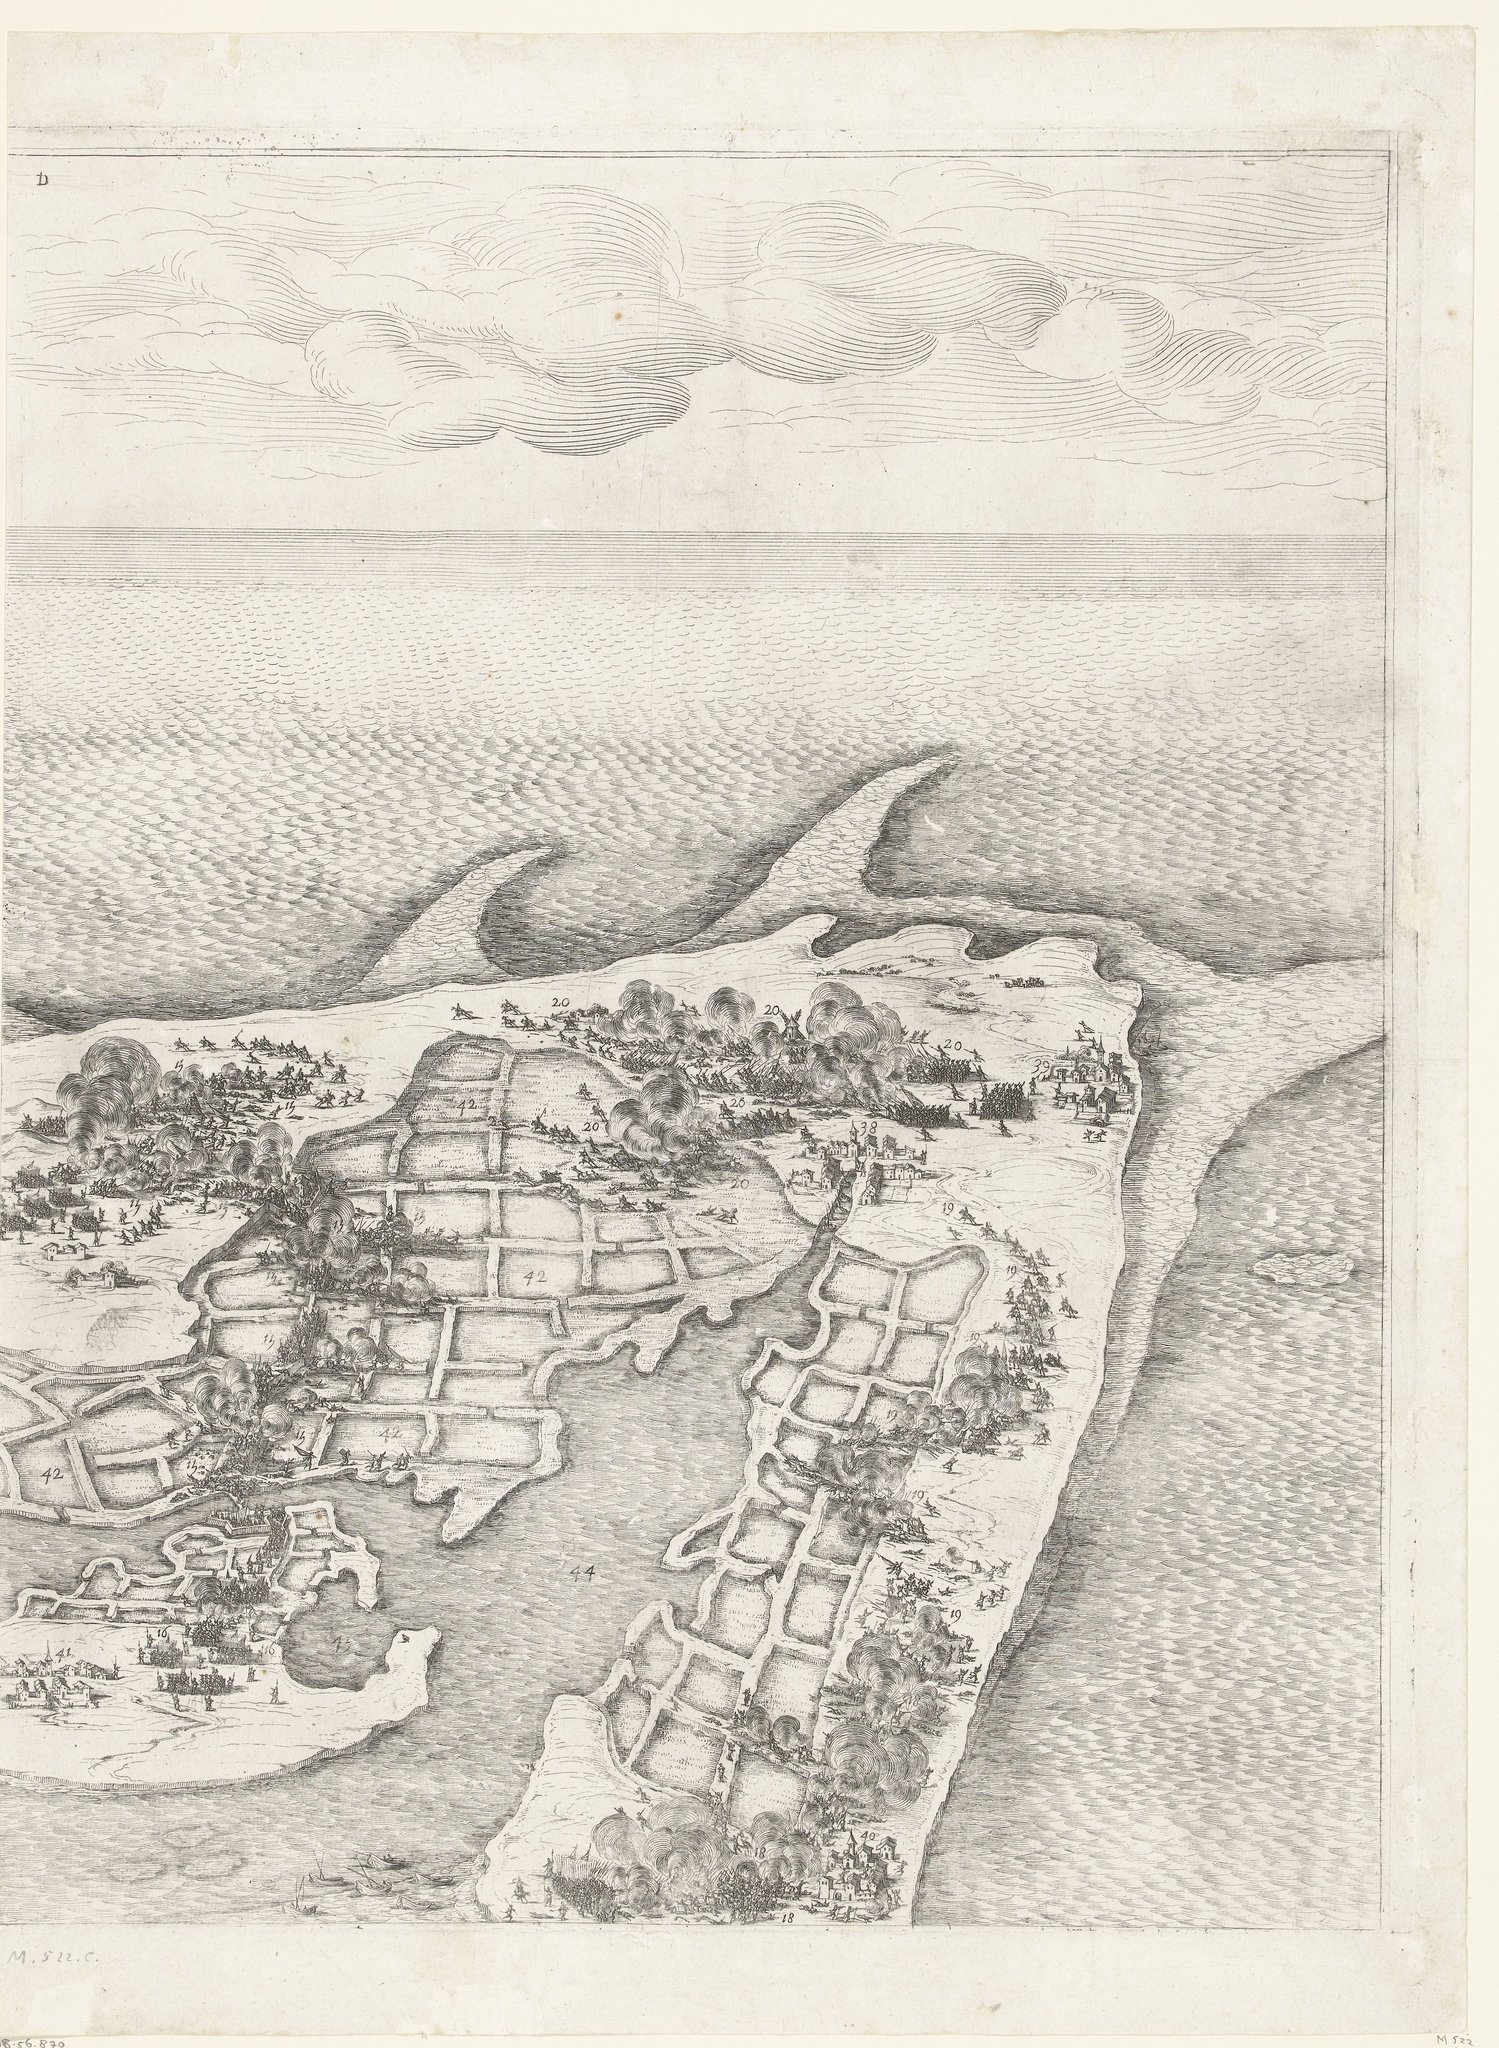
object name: print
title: Beleg van Saint Martin op het Île de Ré, juli-november 1627 (centrale kaart, deel rechtsboven)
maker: jacques callot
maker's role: draughtsman, print maker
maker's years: 1592-1635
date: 1629-1631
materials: paper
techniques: etching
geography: paris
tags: maps of separate countries or regions, battle, siege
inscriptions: collector's mark: Lugt 240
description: Zestiende deel (centrale kaart, deel rechtsboven) van een prent van het beleg van de citadel Saint Martin op het Île de Ré in 1627, dat werd uitgevoerd door Engelse troepen onder leiding van de hertog van Buckingham en werd beëindigd door Franse troepen onder leiding van kardinaal Richelieu. Op dit blad de westelijke punt van het eiland, waarop verschillende gevechten plaatsvinden.